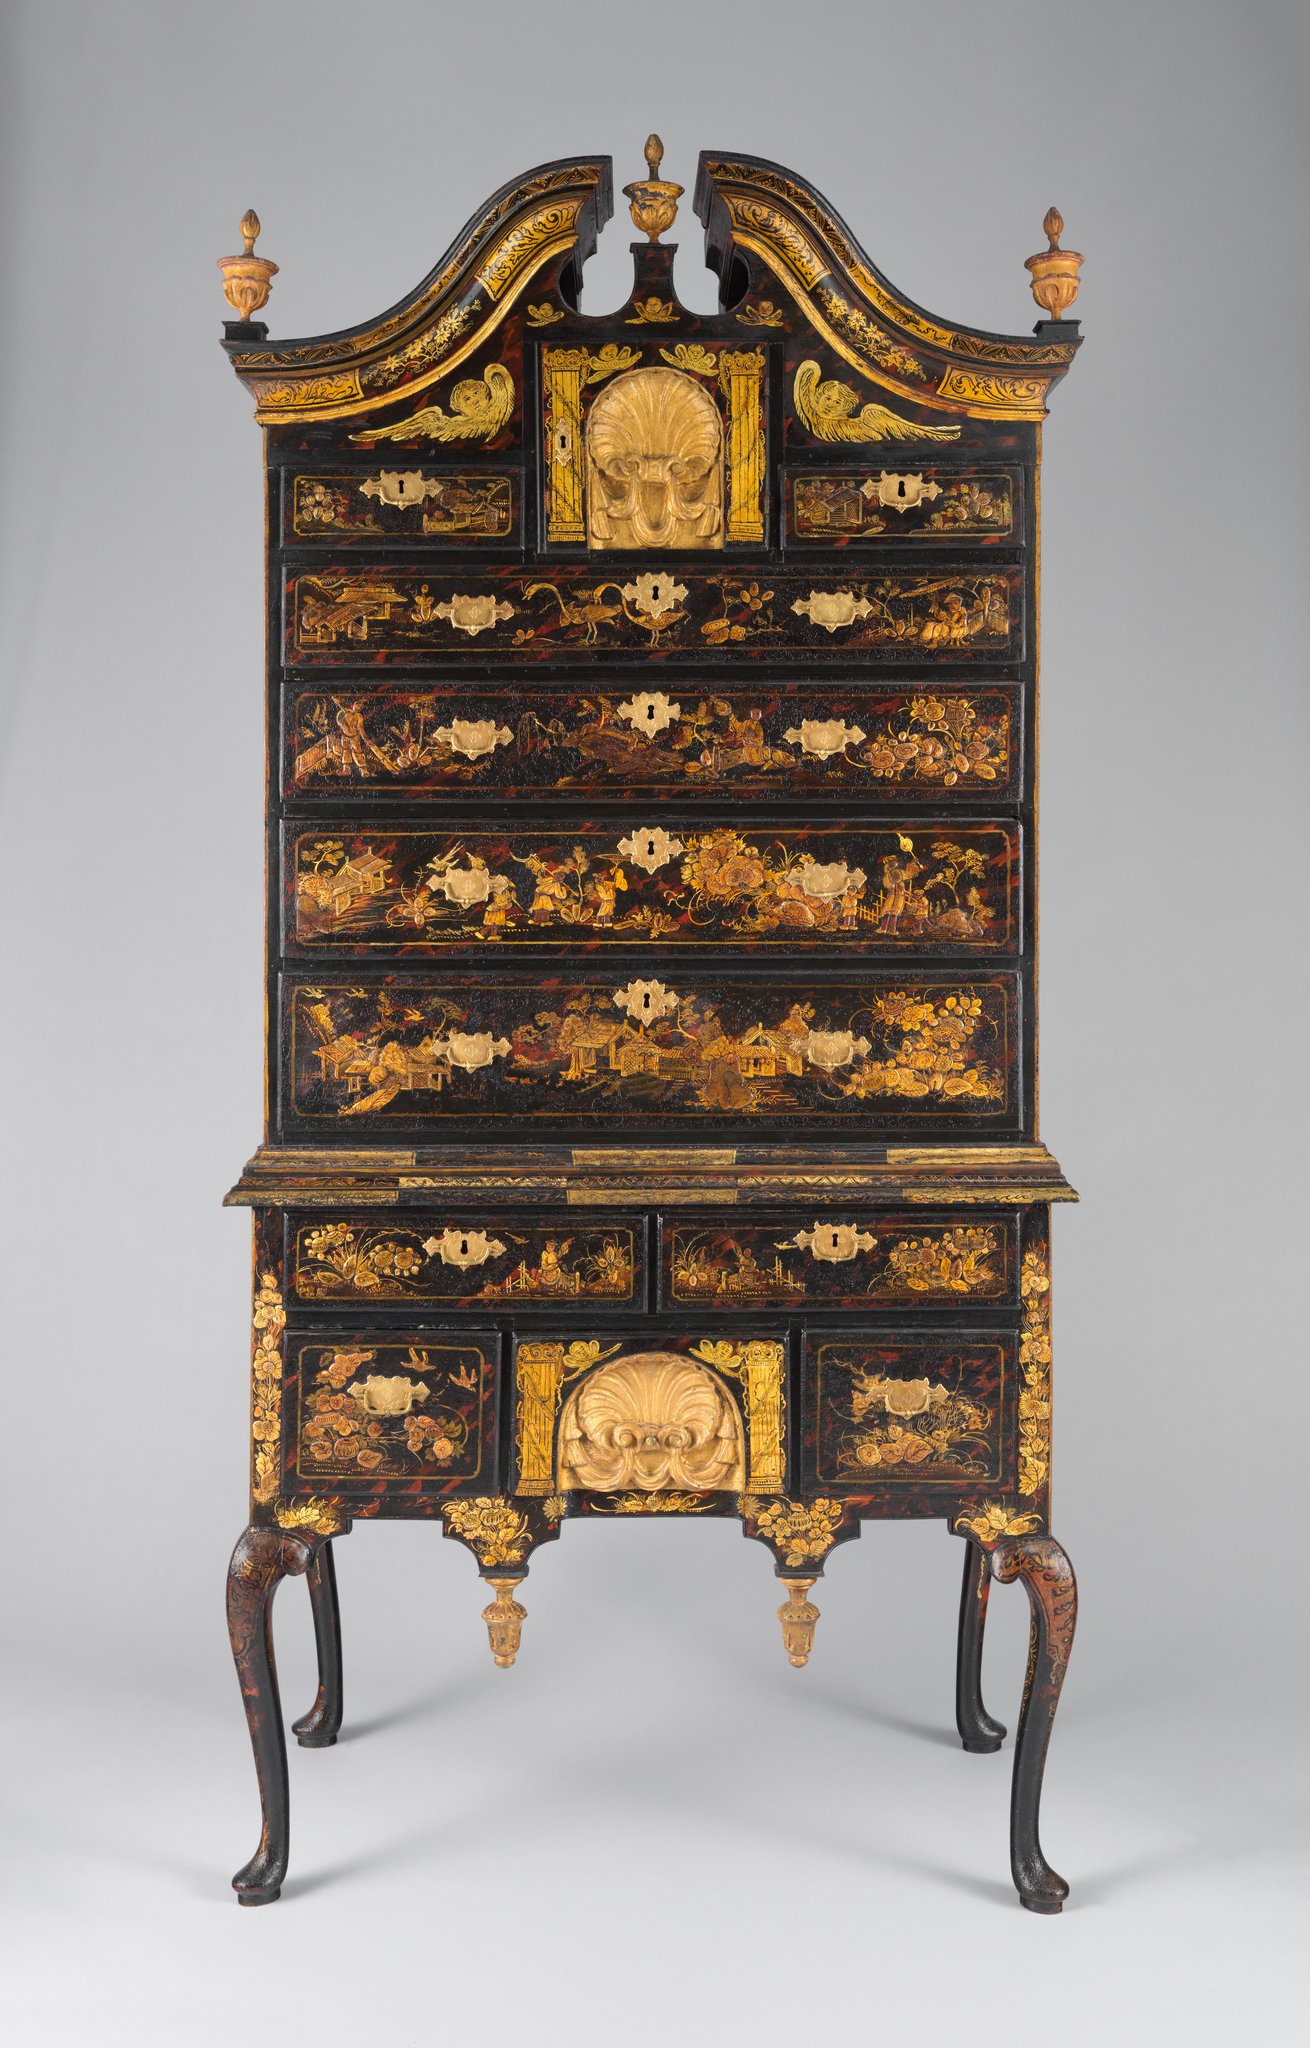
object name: high chest of drawer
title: High chest of drawers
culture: american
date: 1740-1760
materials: wood, brass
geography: united states